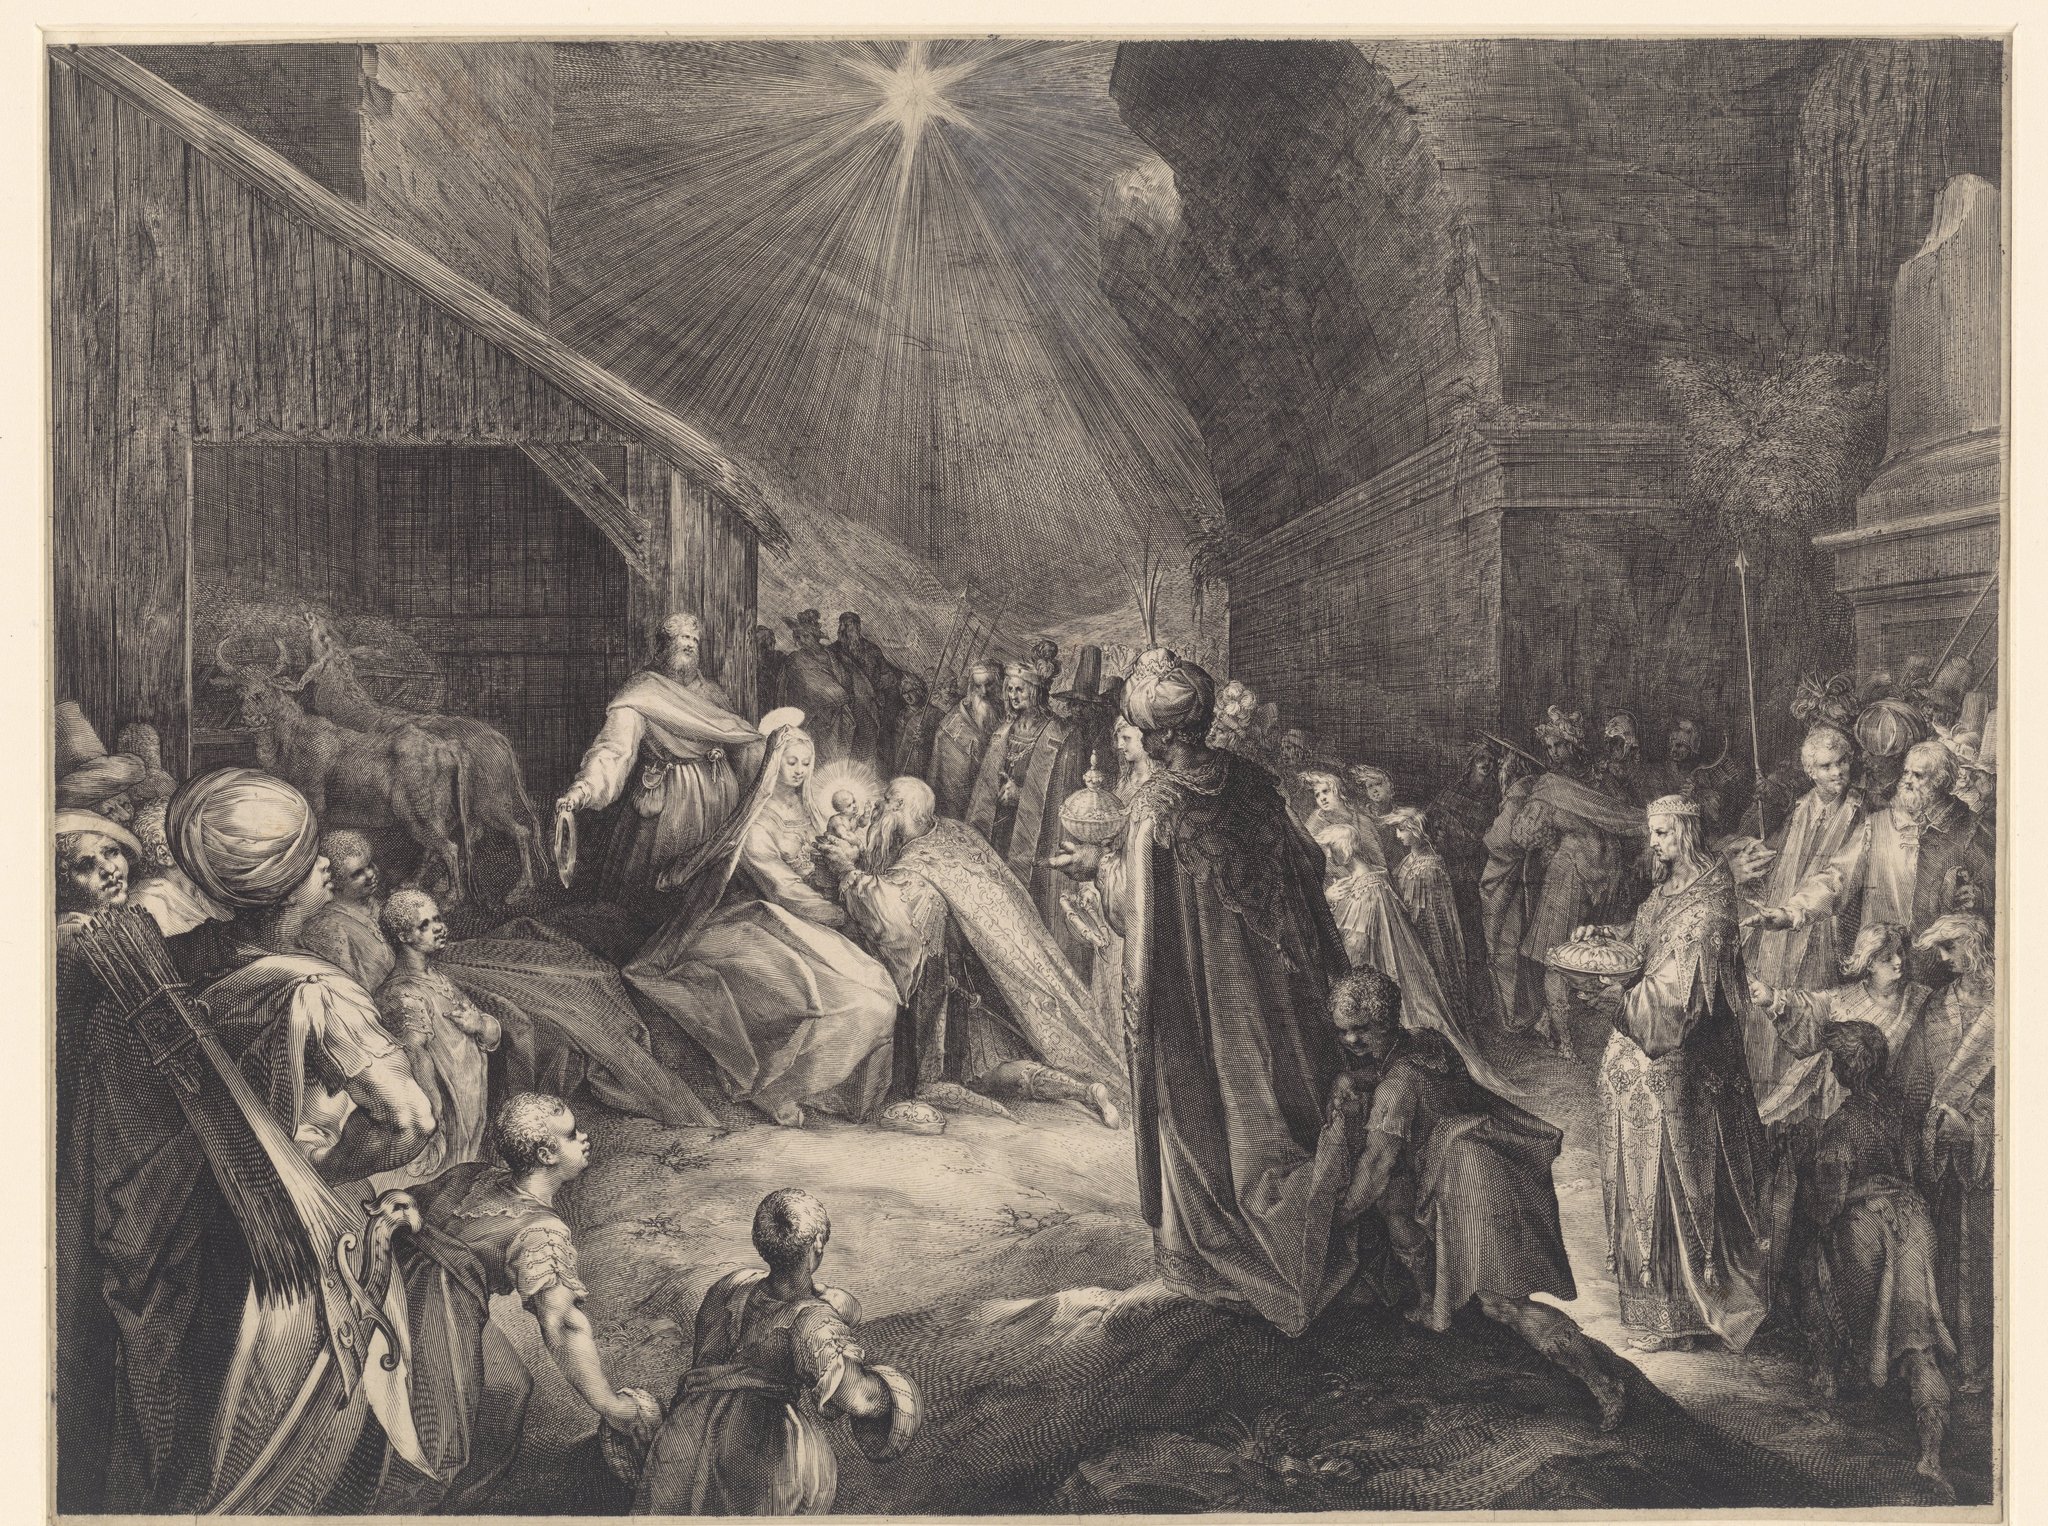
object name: print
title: Aanbidding door de koningen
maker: jan harmensz. muller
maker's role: draughtsman, print maker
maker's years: 1571-1628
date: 1598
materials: paper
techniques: engraving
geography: amsterdam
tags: adoration of the kings: the wise men present their gifts to the christ-child (gold, frankincense and myrrh)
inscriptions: collector's mark: Lugt 1494, collector's mark: Lugt 2228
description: De drie koningen en hun gevolg aanbidden het Christuskind. Een koning knielt voor het Kind. Links de stal met de os en de ezel. Aan de hemel de ster.